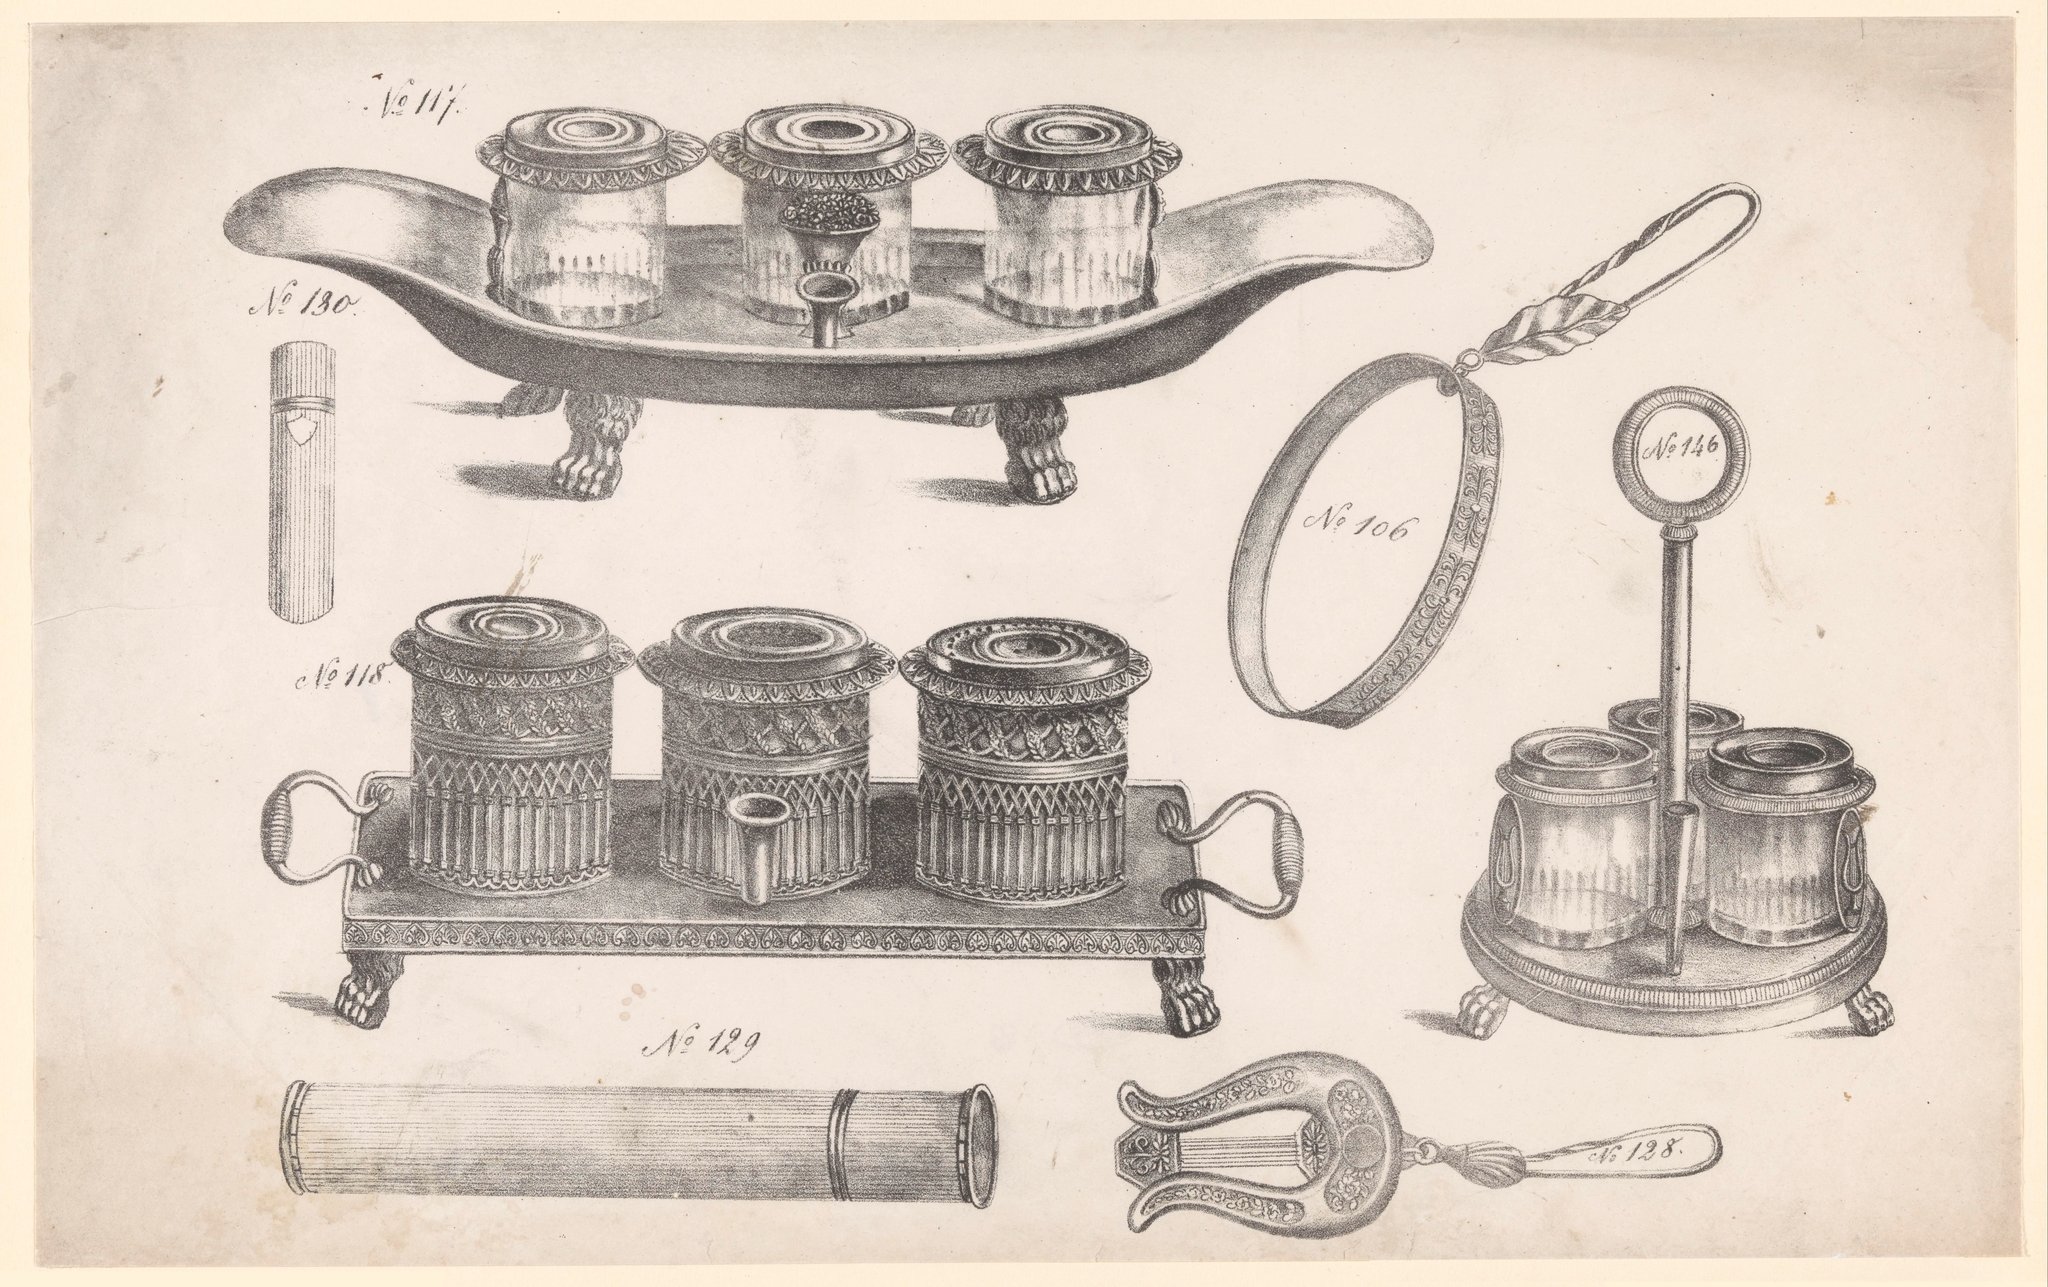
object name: print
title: Empirevoorwerpen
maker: Anonymous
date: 1820-1840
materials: paper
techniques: lithograph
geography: germany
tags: styles in the fine arts (+ later developments), seasonings, spices, salt-cellar, salt-shaker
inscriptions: collector's mark: Lugt 2228, collector's mark: Lugt 2760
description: Waarschijnlijk onderdeel van een catalogus. Mogelijke prentmaker of drukker is Firma Leudesdorf-Mansfeld te Elberfeld. Zie RP-P-1965-504 en 505.